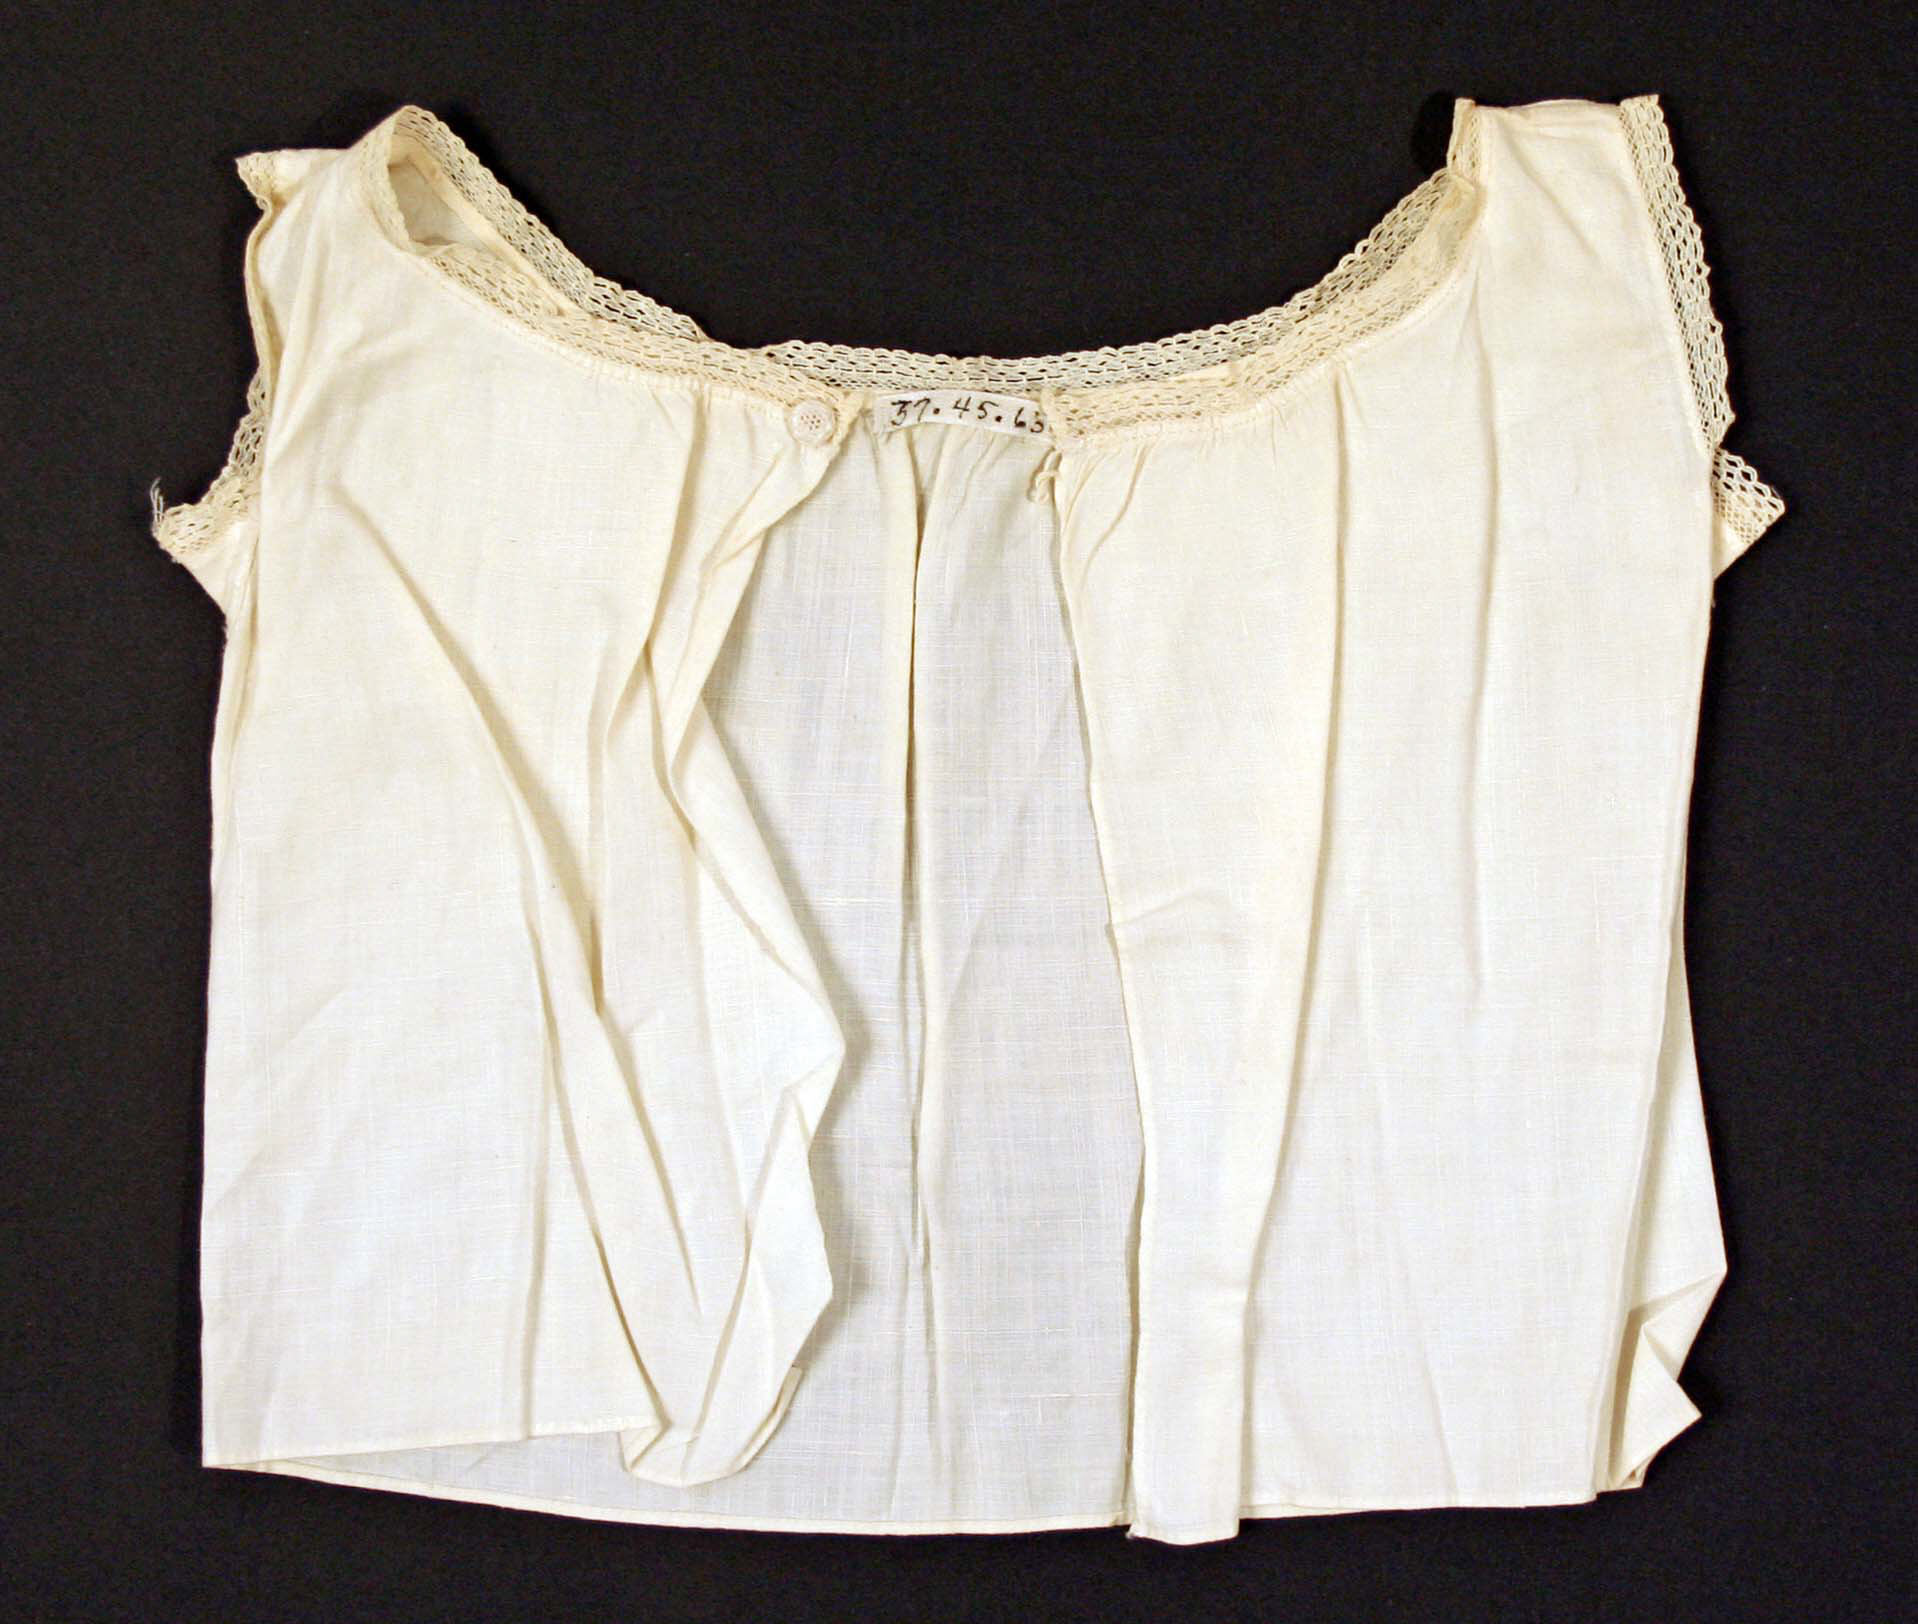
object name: shirt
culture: american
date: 1781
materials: linen